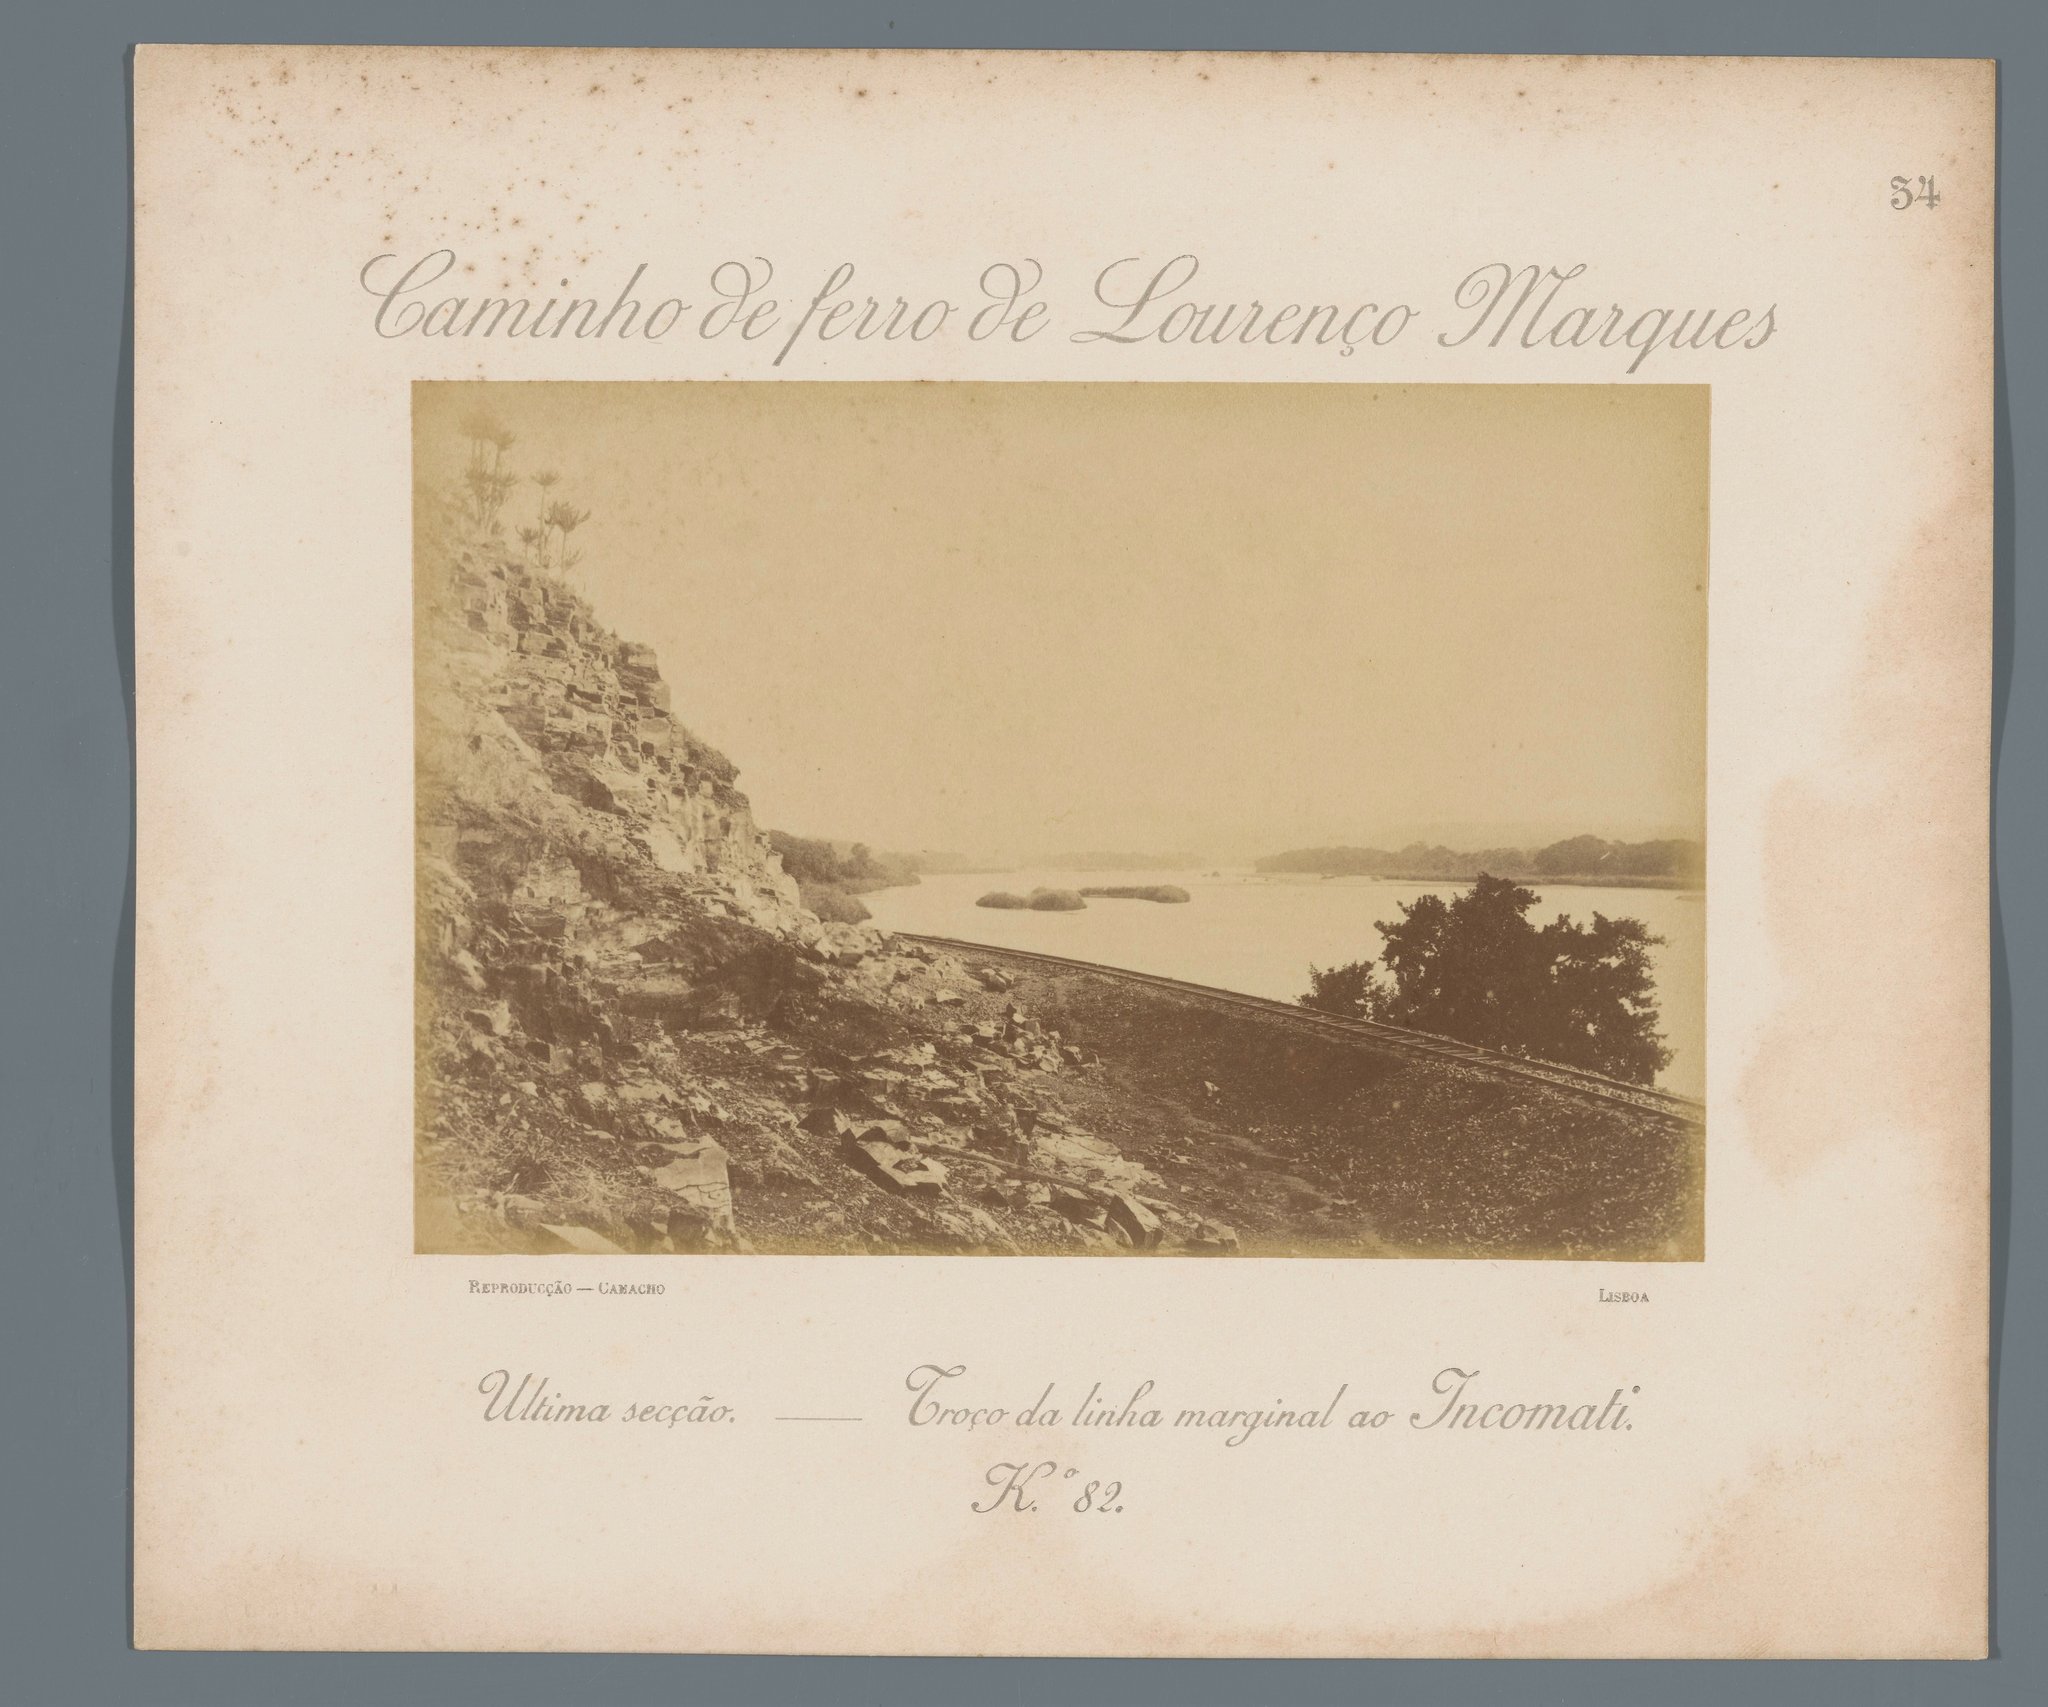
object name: photograph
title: Caminho de ferro de Lourenço Marques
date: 1886-1895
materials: photographic support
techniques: albumen print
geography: lisbon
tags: river, railway, train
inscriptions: number: ‘34’